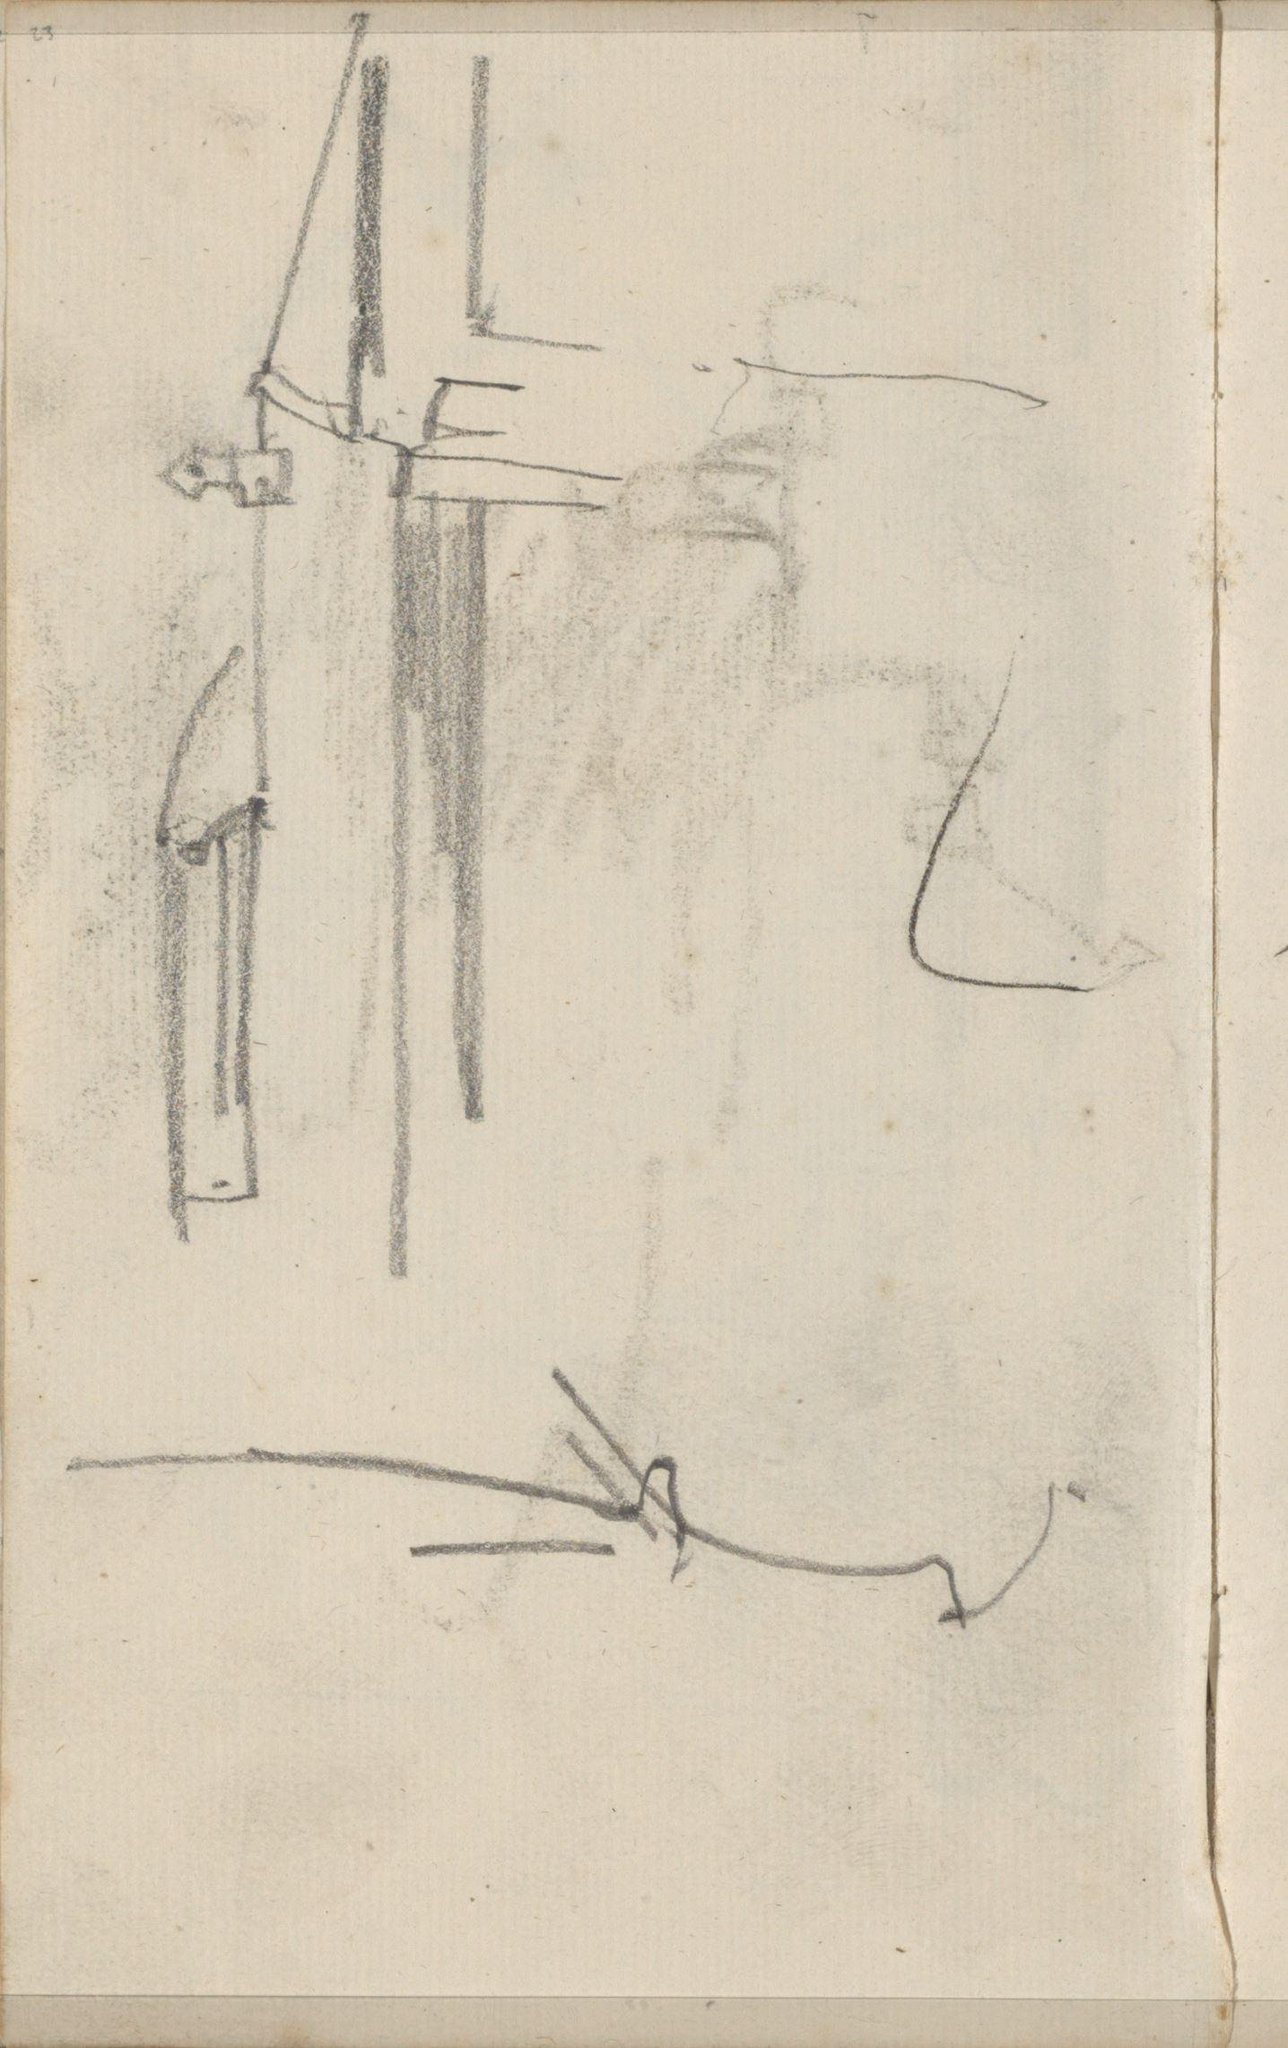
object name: sketchbook leaf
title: Dak van een gebouw of paardentram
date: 1880-1882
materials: paper, pencil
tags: diligence, omnibus, horse-tram, roof (of house or building)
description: Pagina 23 uit een schetsboek met 31 bladen.